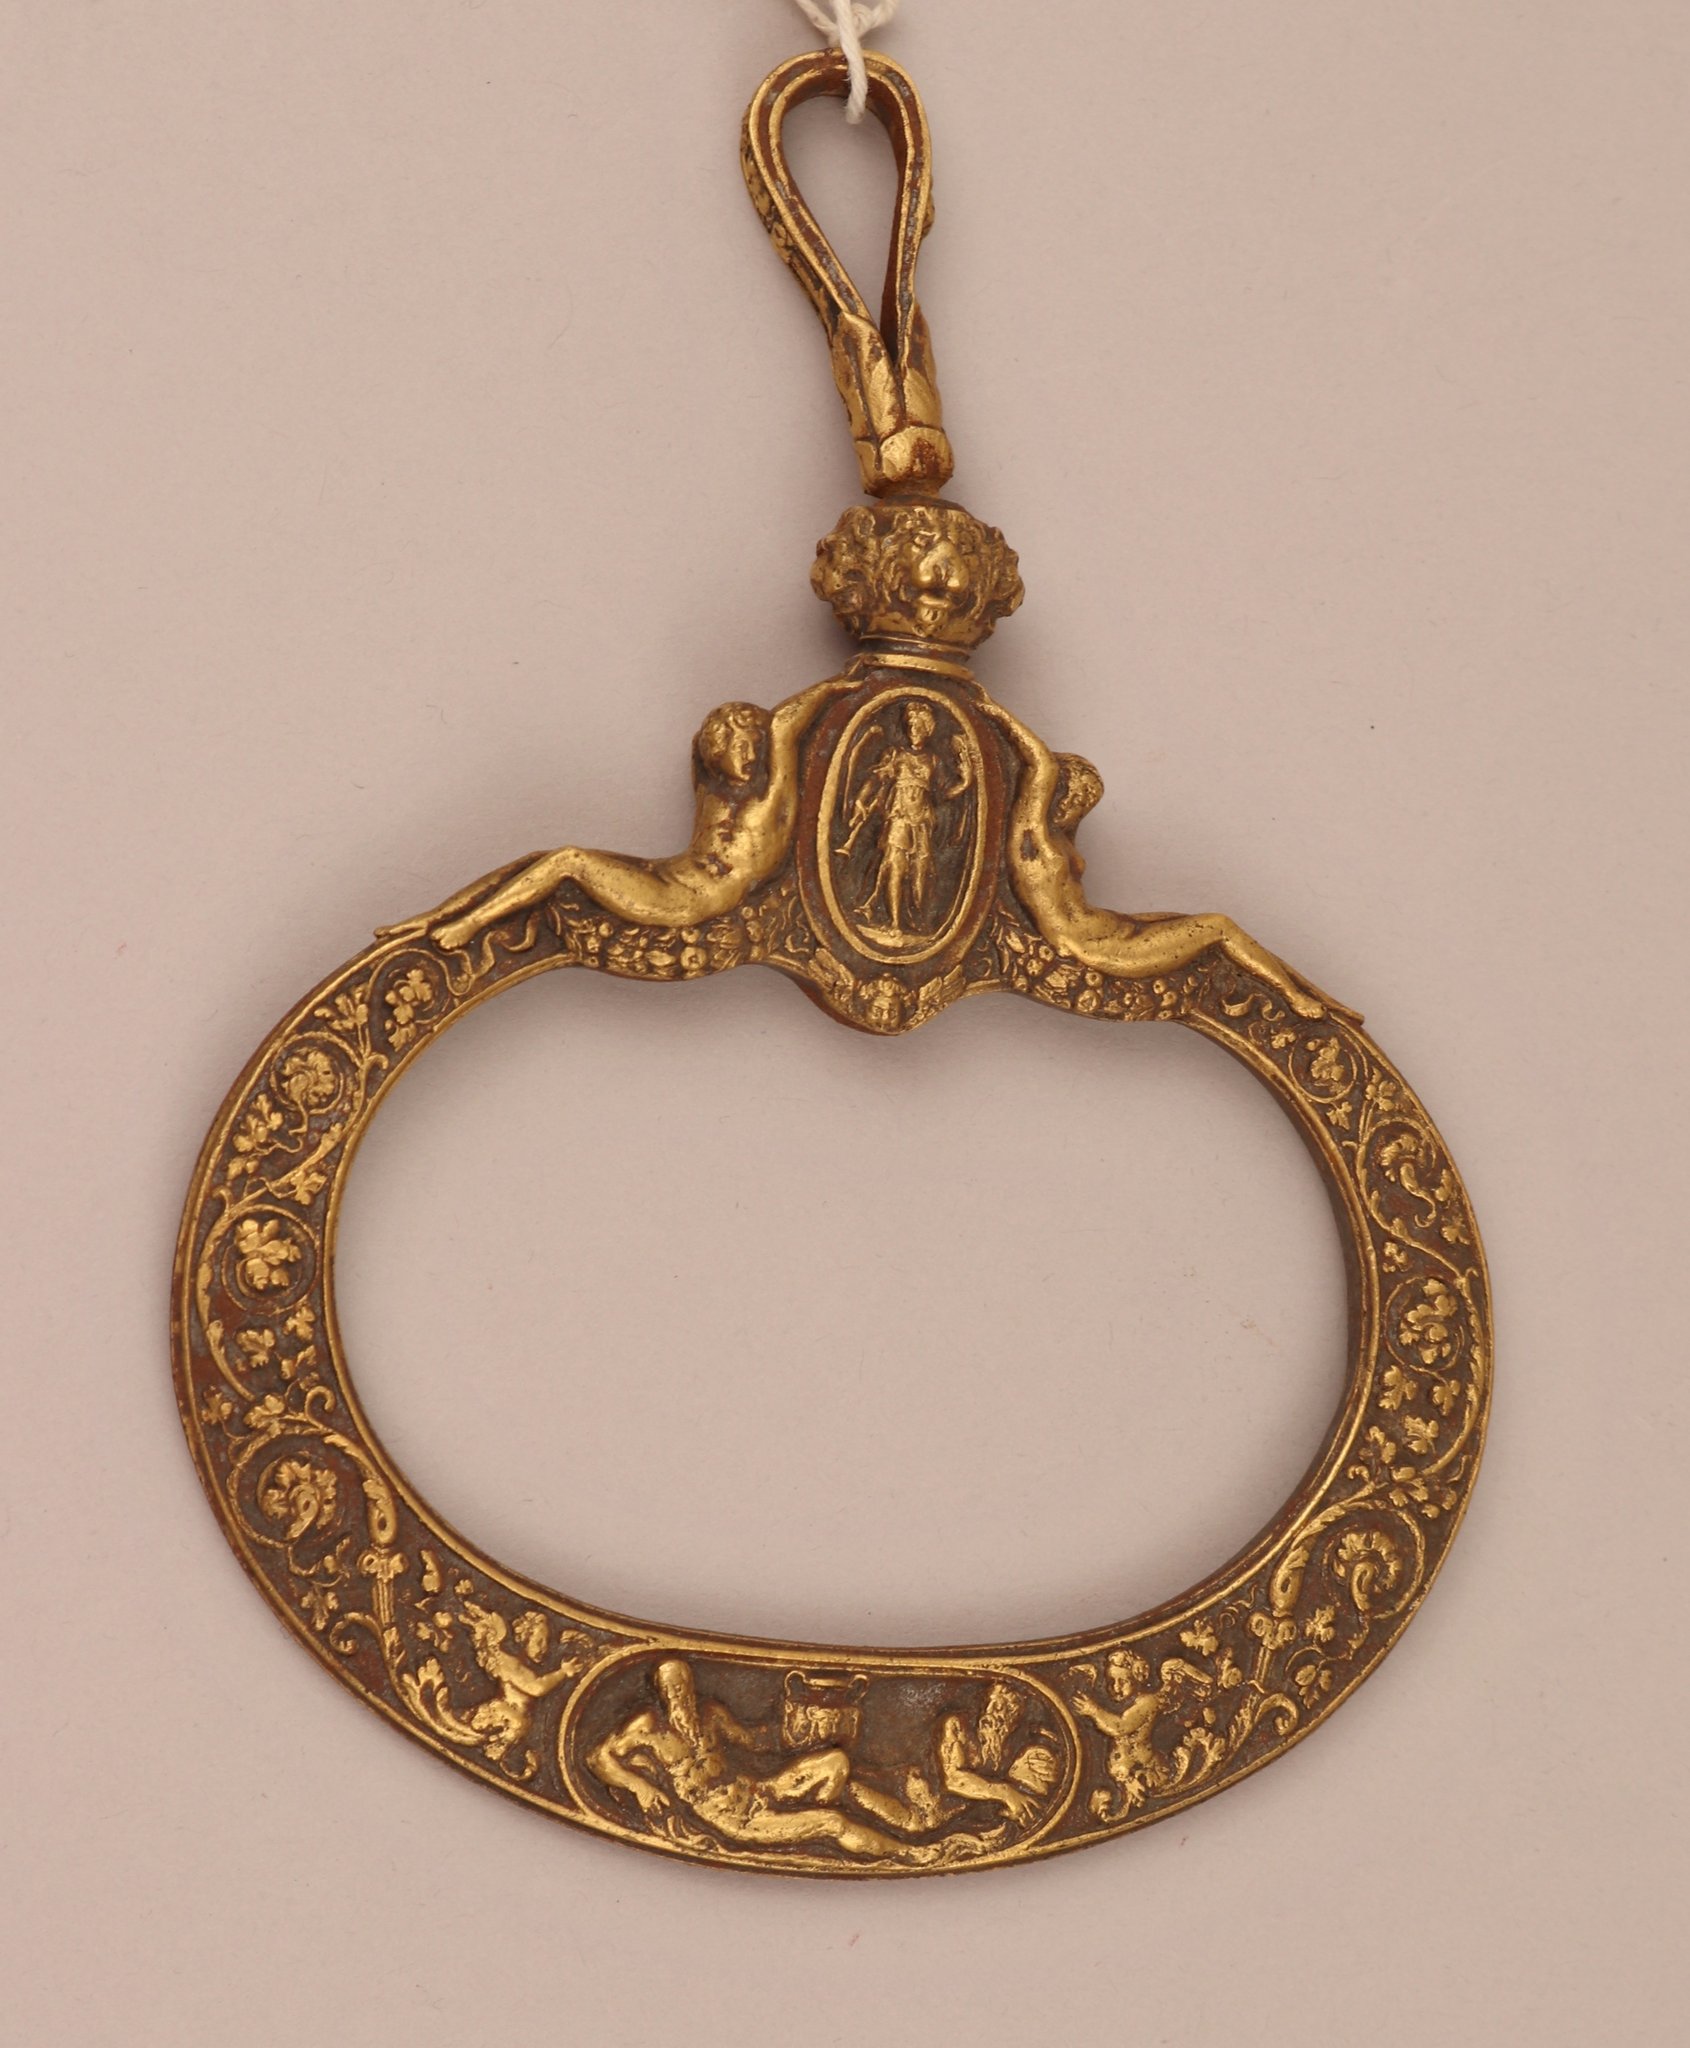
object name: purse mount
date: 1801-1900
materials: gilt, iron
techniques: chasing